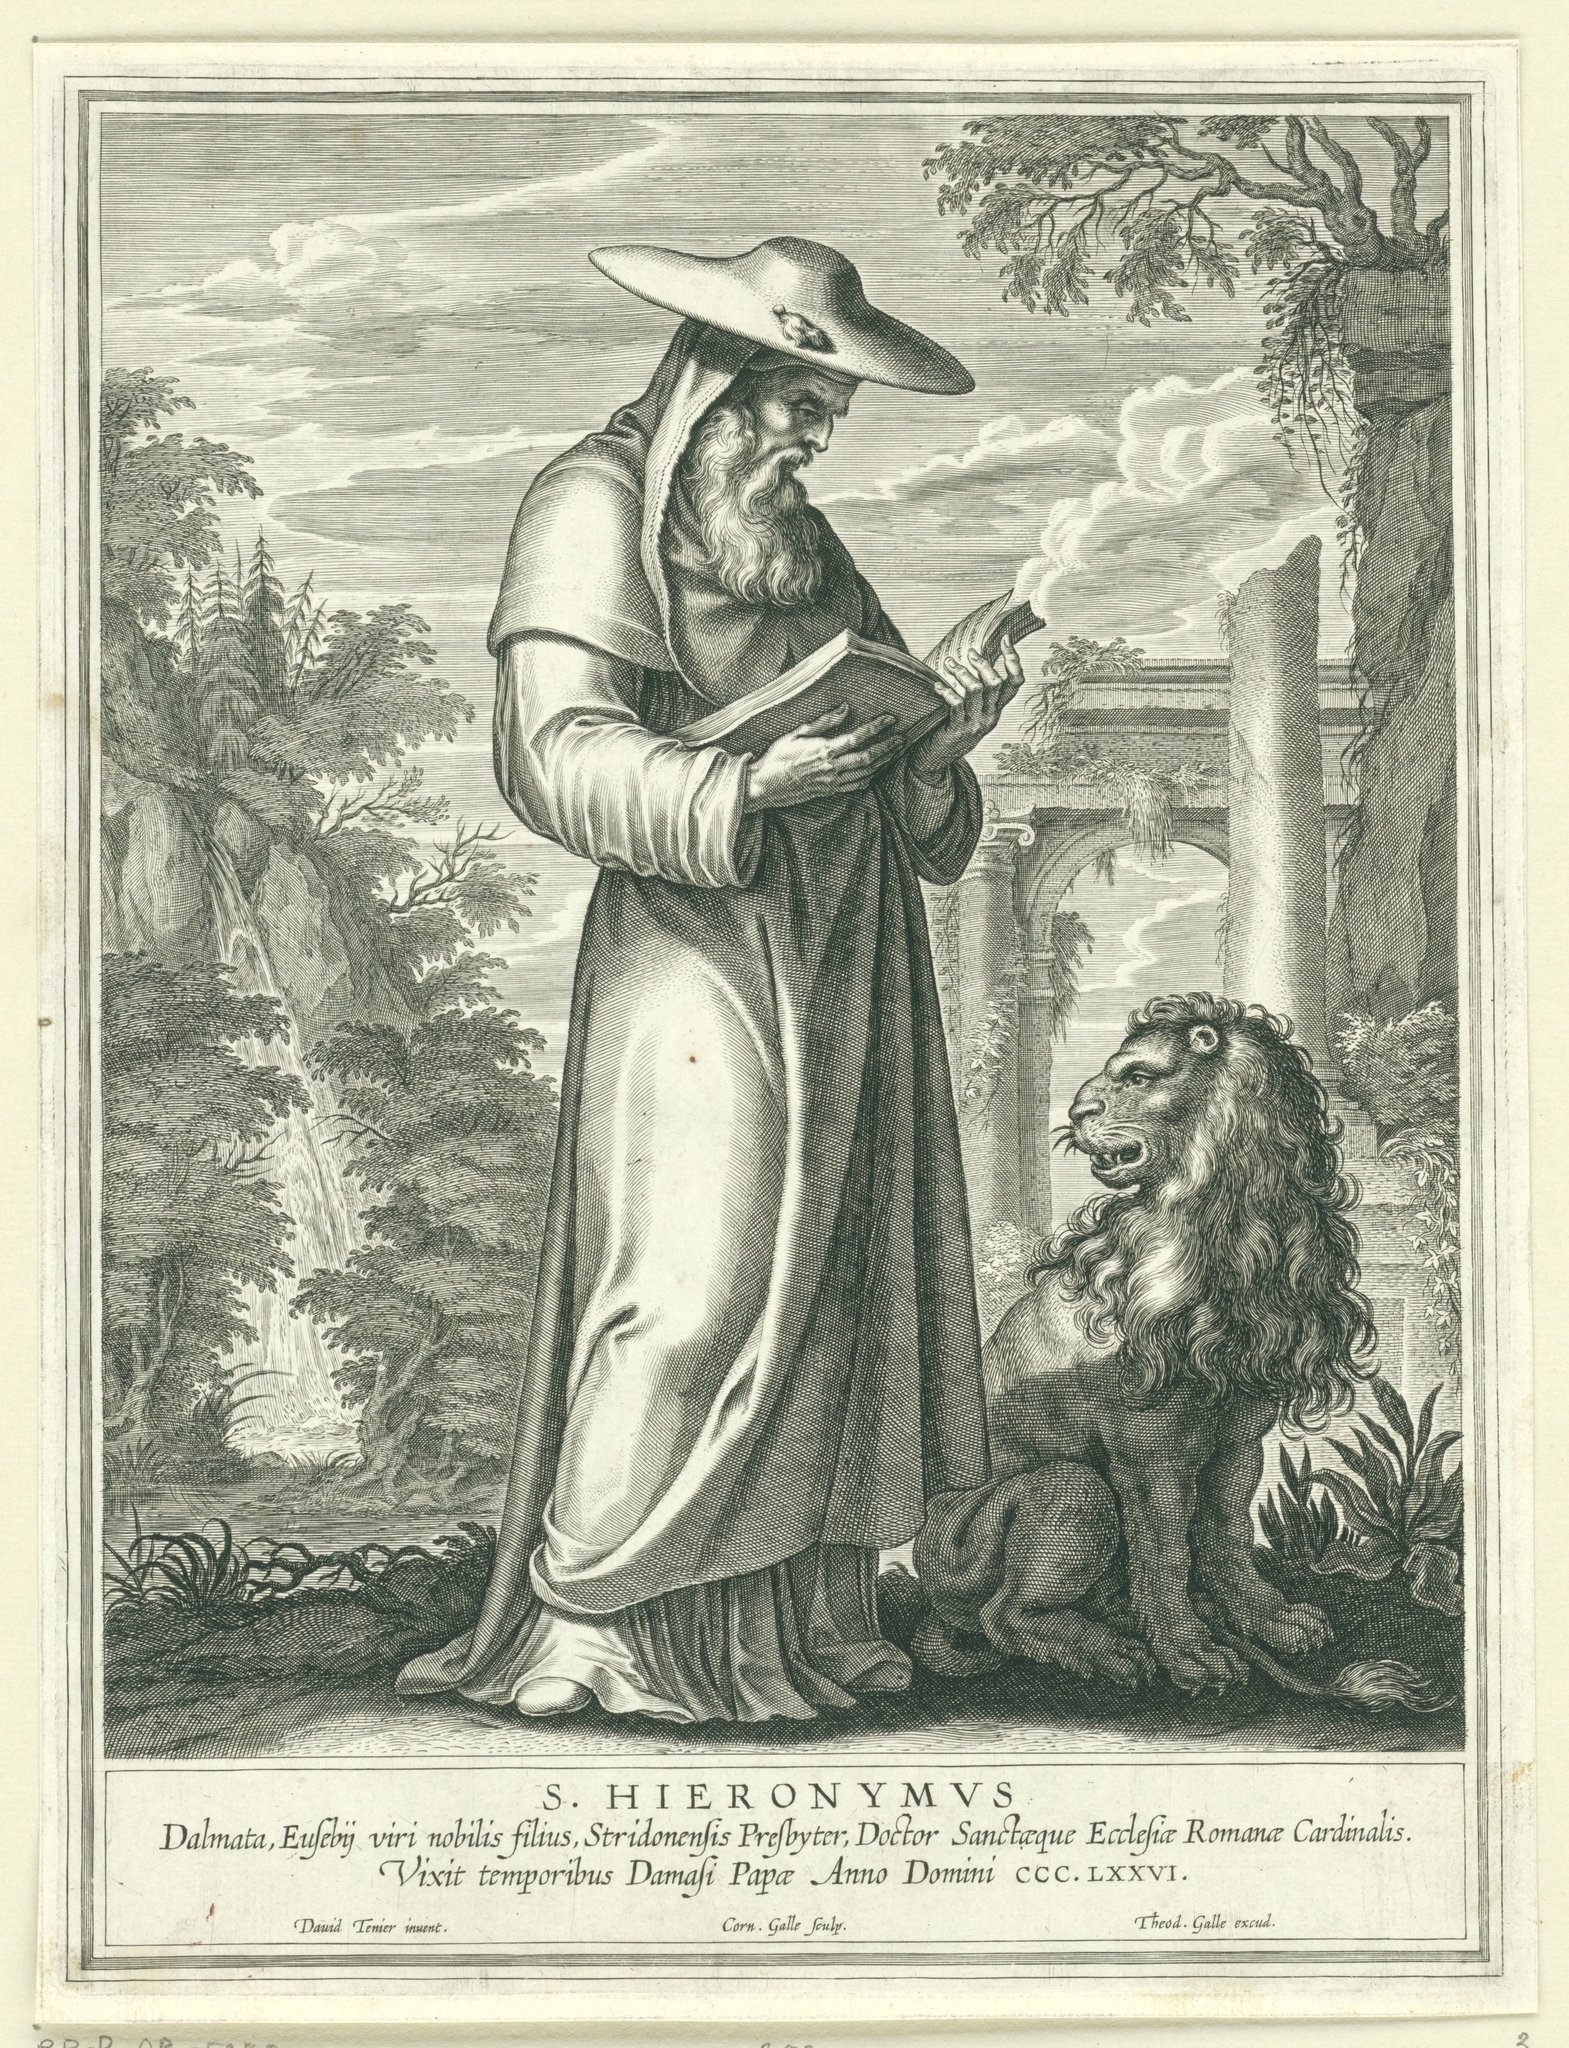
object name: print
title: H. Hieronymus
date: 1610-1633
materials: paper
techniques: engraving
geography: antwerp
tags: specific aspects ~ st. jerome - male saint as patron, protector, intercessor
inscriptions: collector's mark: Lugt 240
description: De heilige Hieronymus staand in een landschap. Hij leest in een boek, naast hem zijn attribuut de leeuw. Op de achtergrond een Romeinse ruïne.